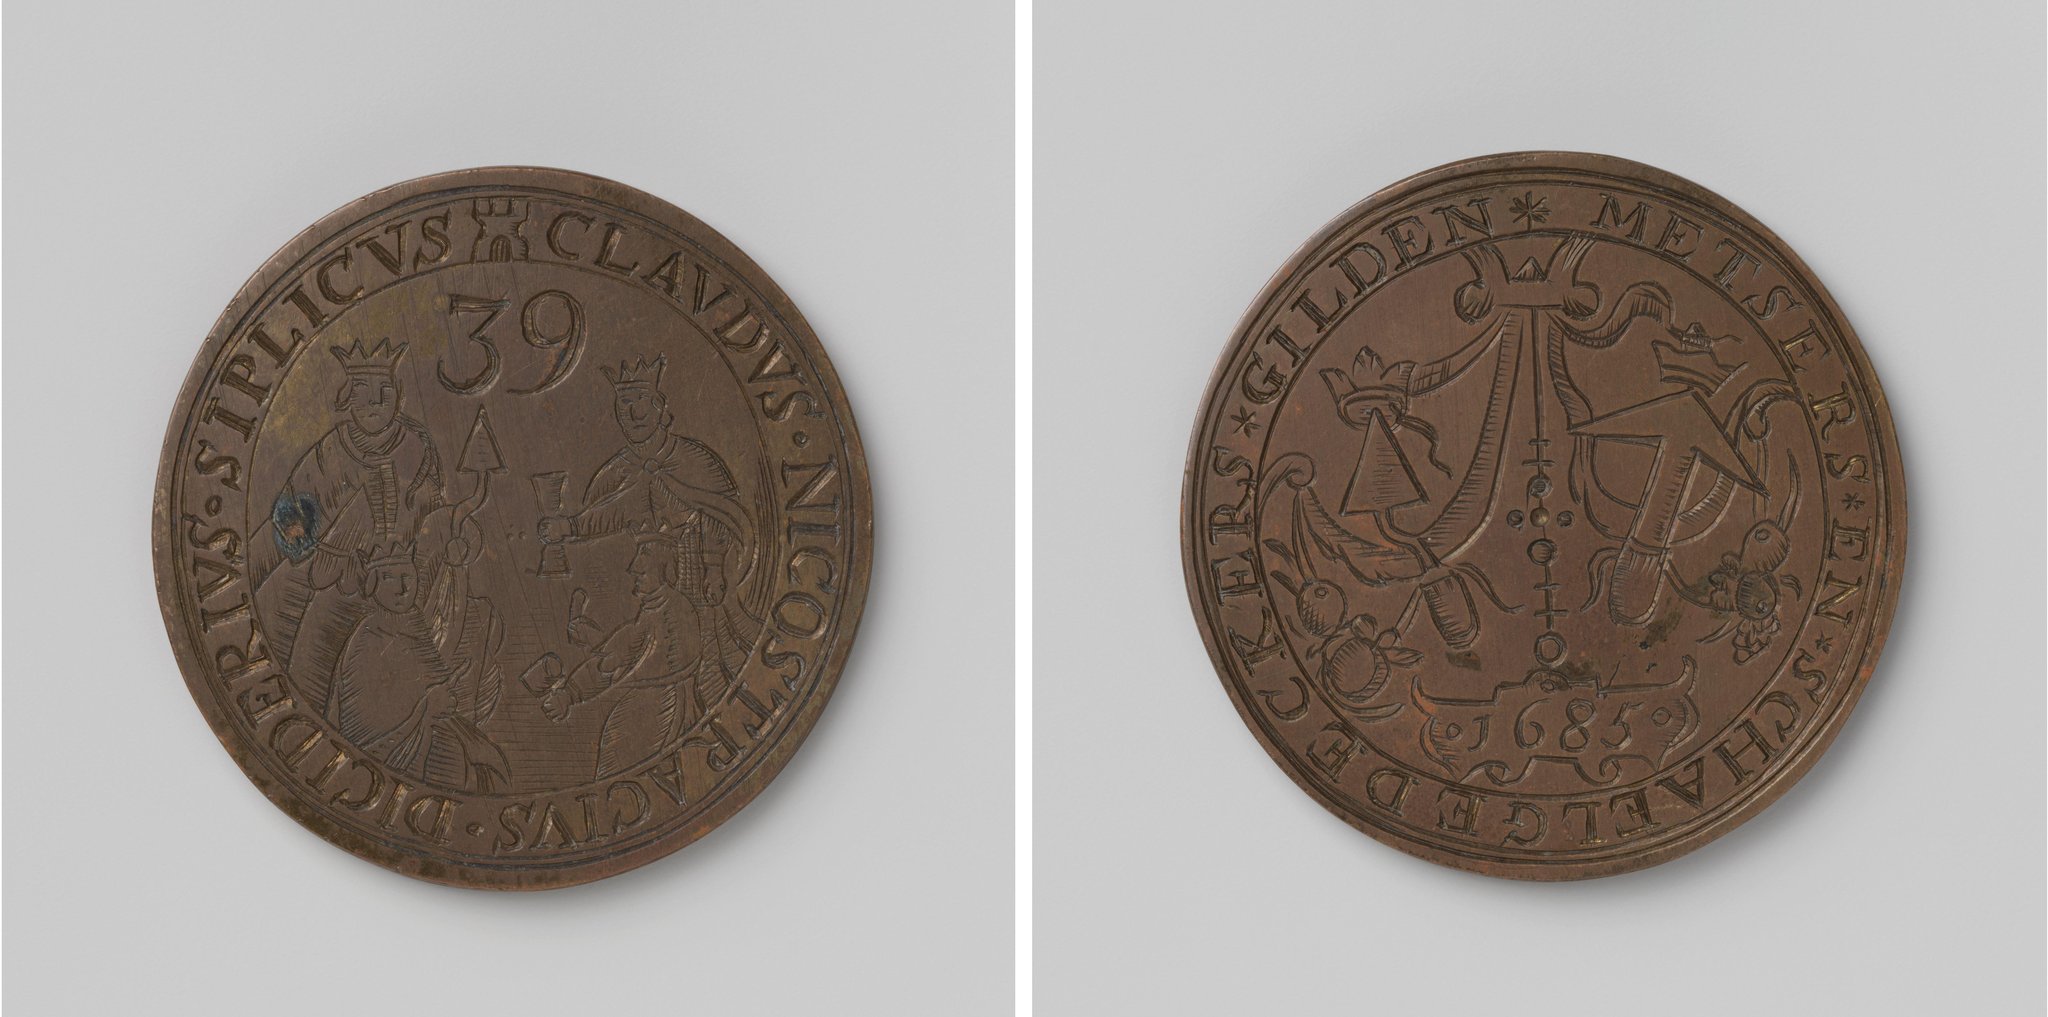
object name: medal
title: Metselaars- , leidekkers- en loodgietersgilde van Middelburg, gildepenning met no. 39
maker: Anonymous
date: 1685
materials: copper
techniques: engraving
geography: middelburg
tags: middelburg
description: Koperen penning. Voorzijde: vier gekroond eheiligen, waarvan de eerste een troffel, de tweede een pasloodbord [of: tekenplank], de derde een dubbele beitel en de vierde een hamer en een beitel in handen houdt onder cijfer 39 binnen omschrift. Keerzijde: gekroond troffel en gekroonde leidekkers hamer aan een lint, waaruit een paslood hangt omgeven door takken en vruchten boven jaartal in compartiment binnen omschrift